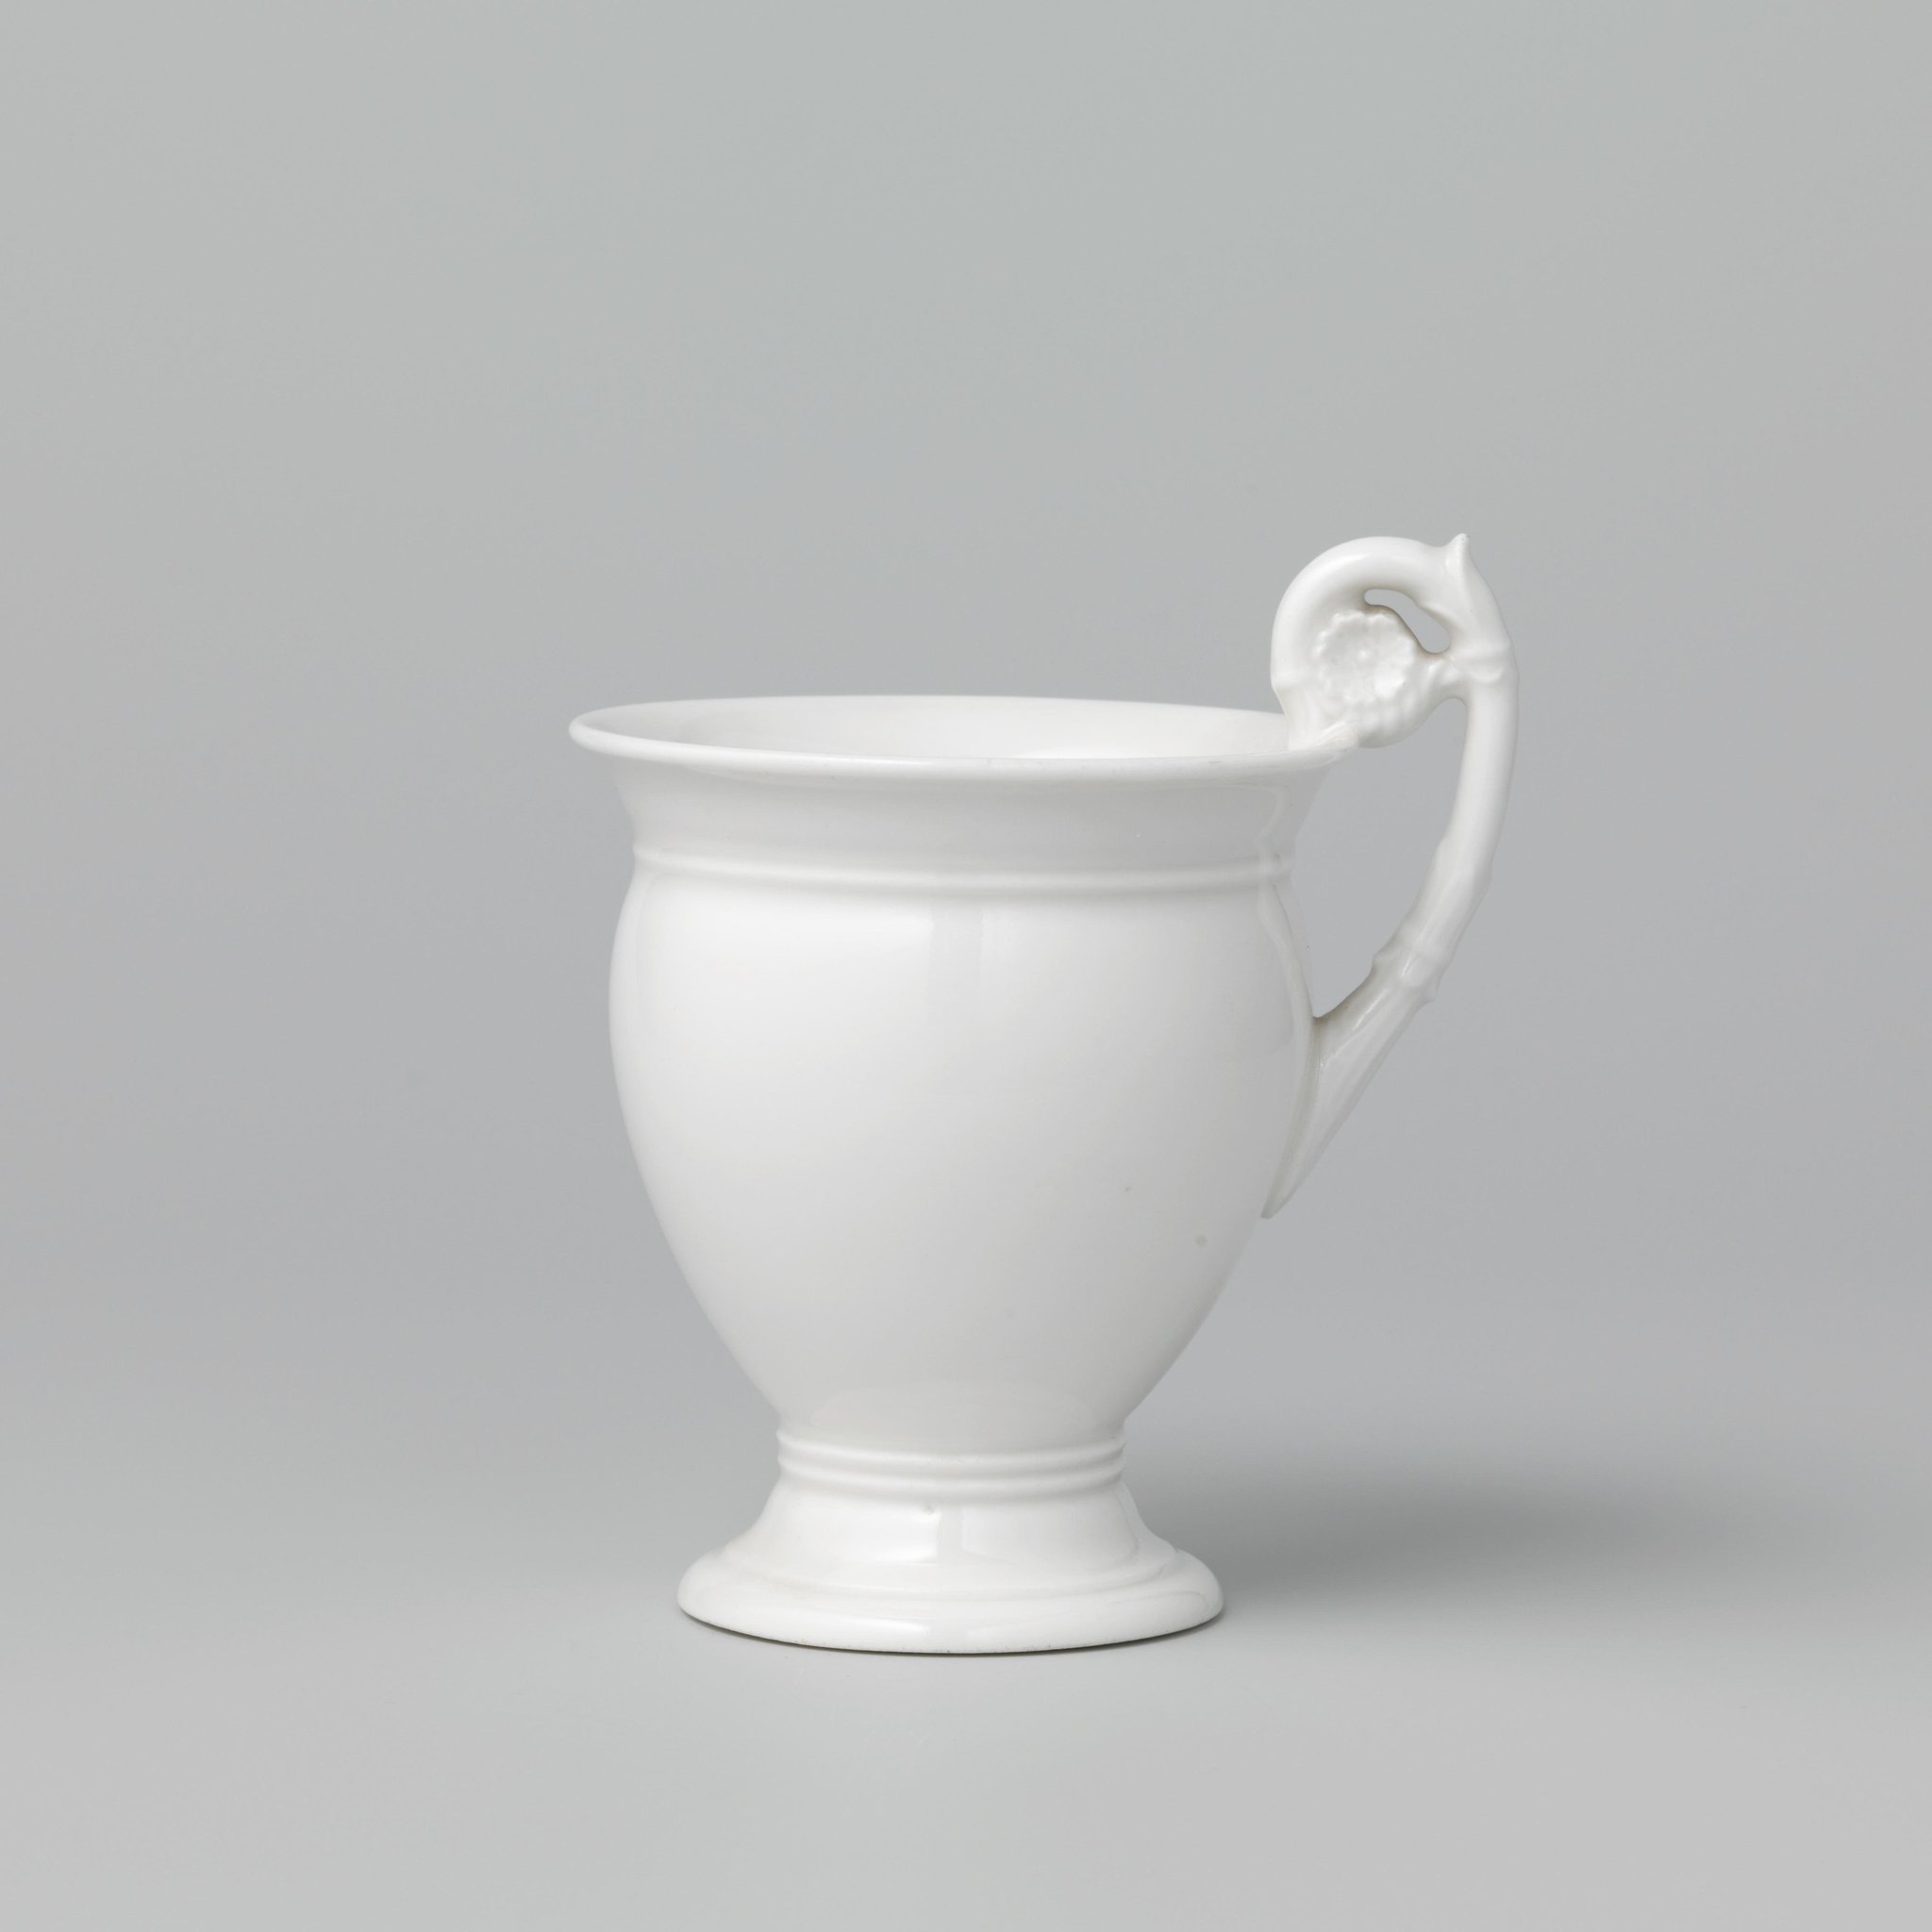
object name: cup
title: White cup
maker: Anonymous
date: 1800-1810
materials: glaze, porcelain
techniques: firing, forming, turning, vitrification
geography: france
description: Kop van wit porselein, op hoge, spreidende voet en uitlopende rand. Het hoge oor is in de vorm van een gekrulde bloemtak.